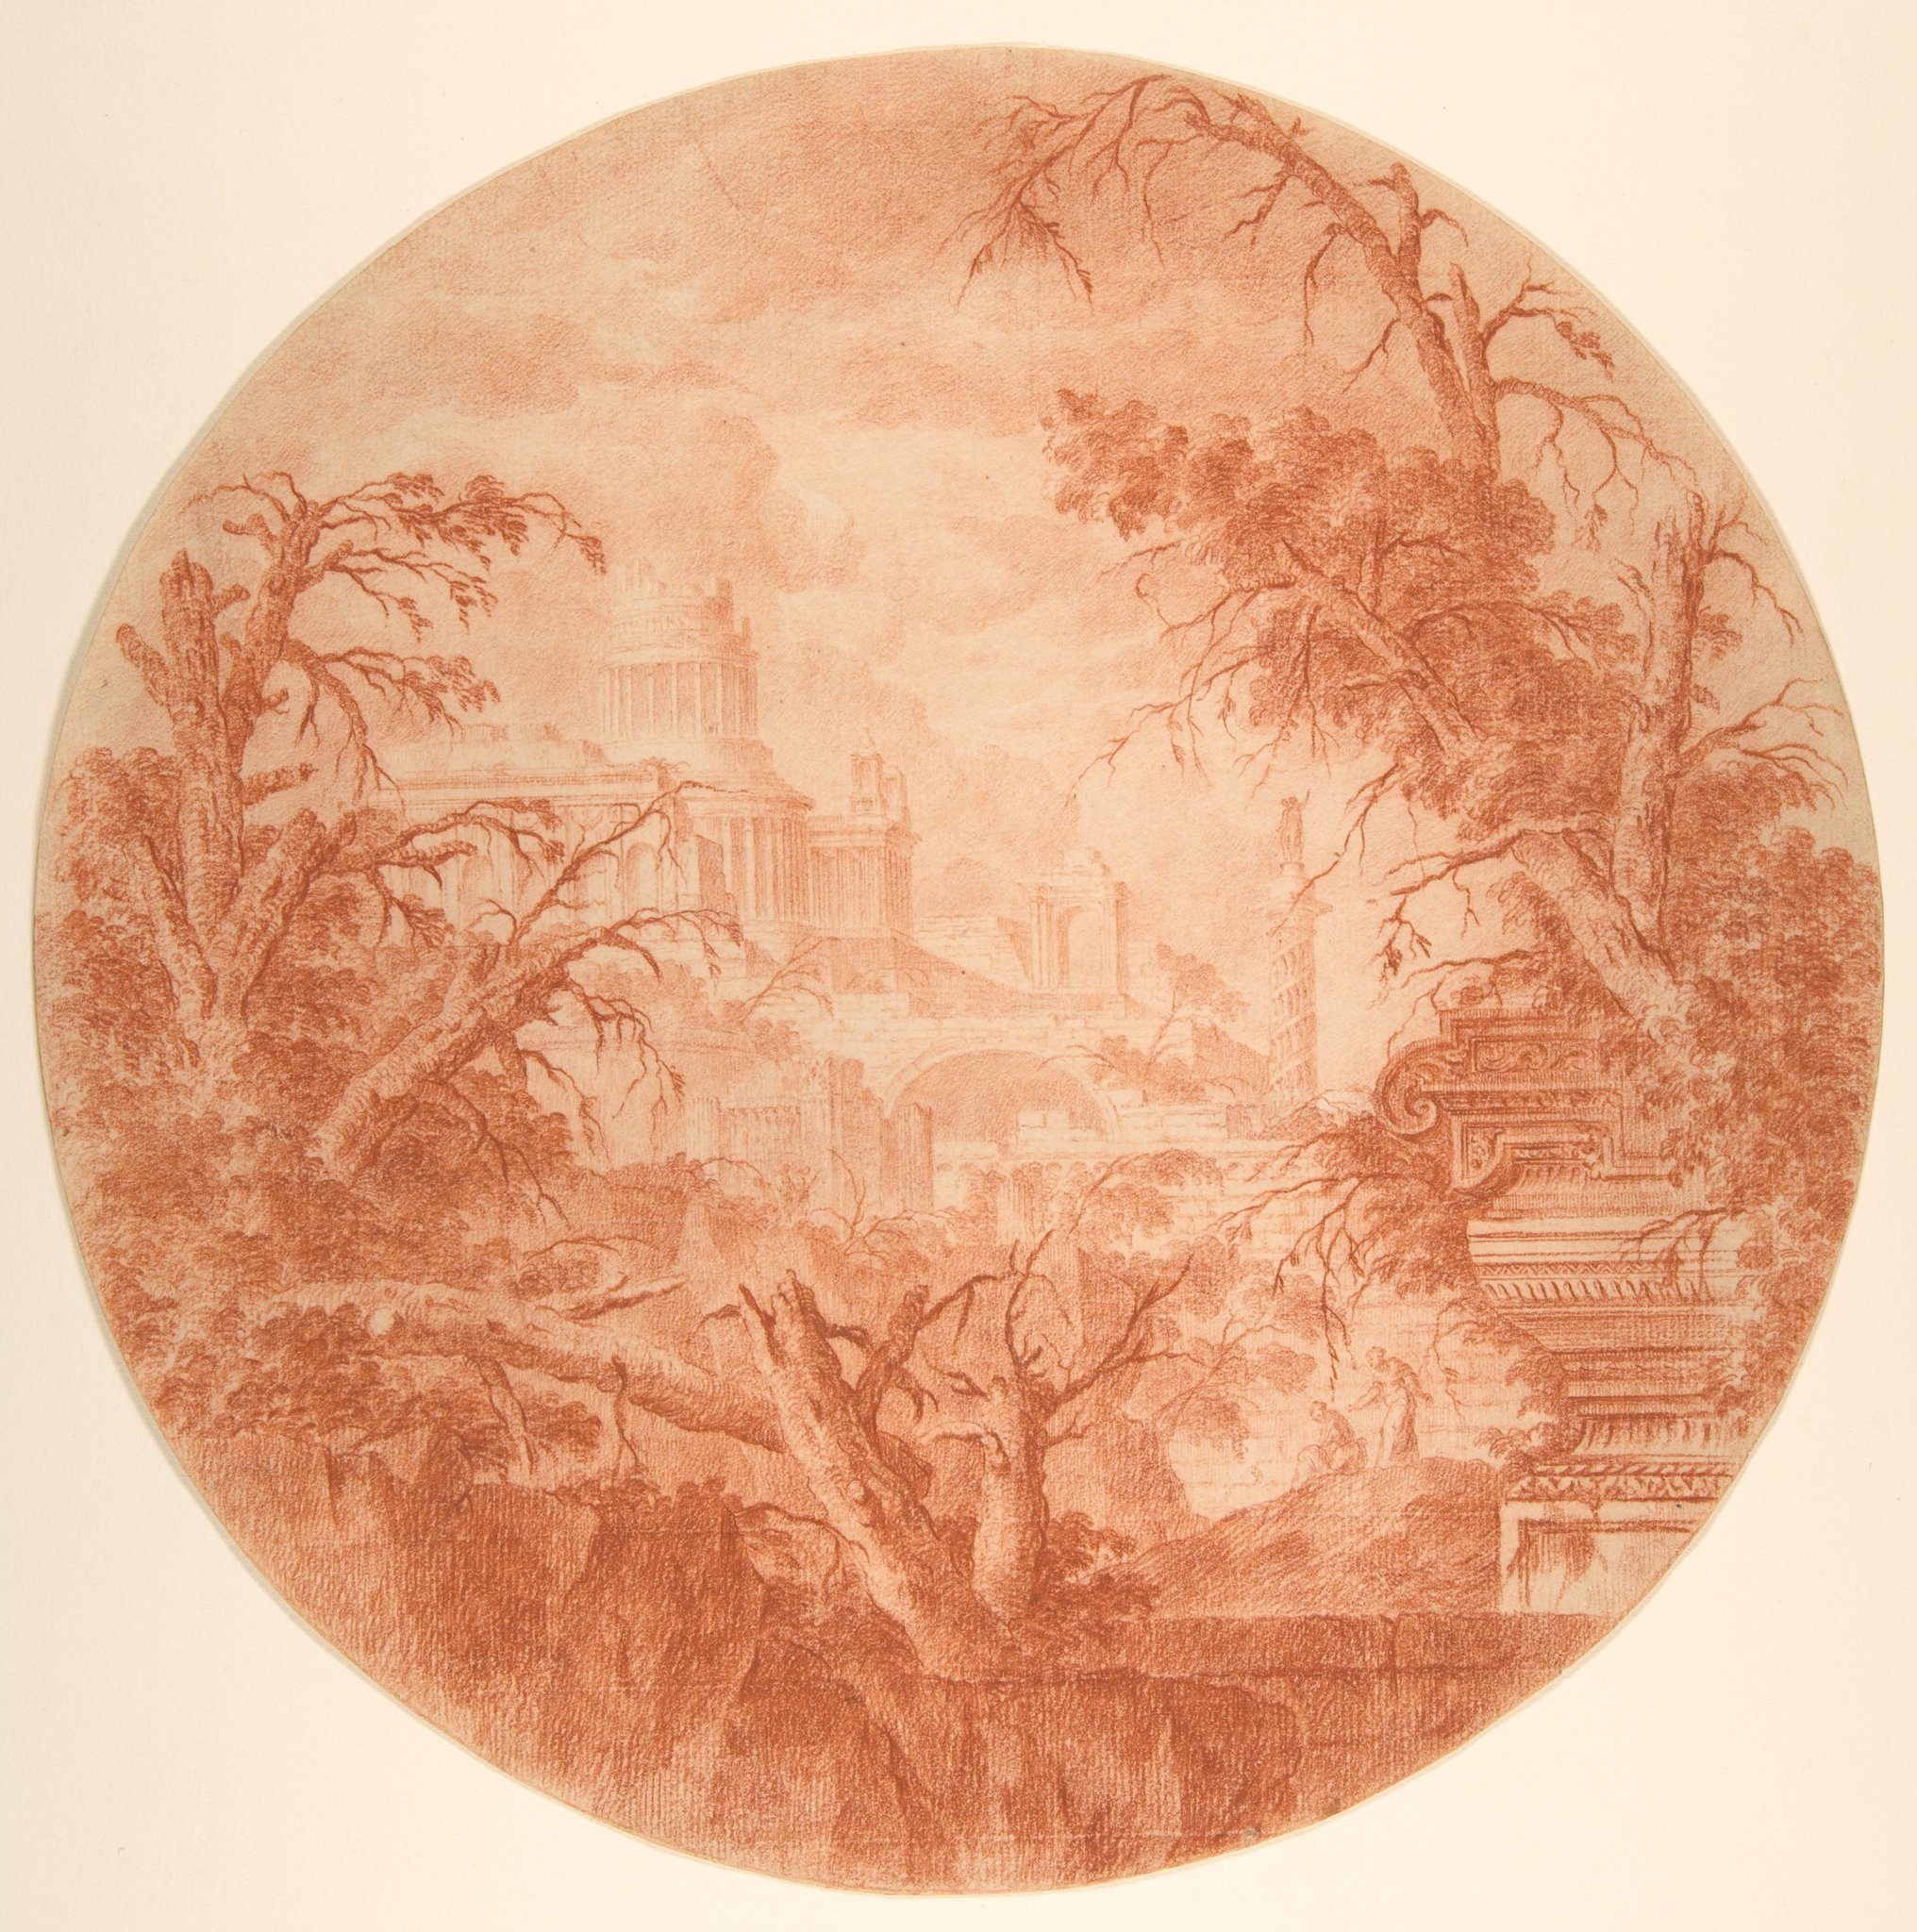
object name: drawing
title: Architectural Fantasy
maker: jean laurent legeay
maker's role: artist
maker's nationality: french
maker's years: 1710-1788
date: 1785-1790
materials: chalk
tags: architecture,palaces,trees